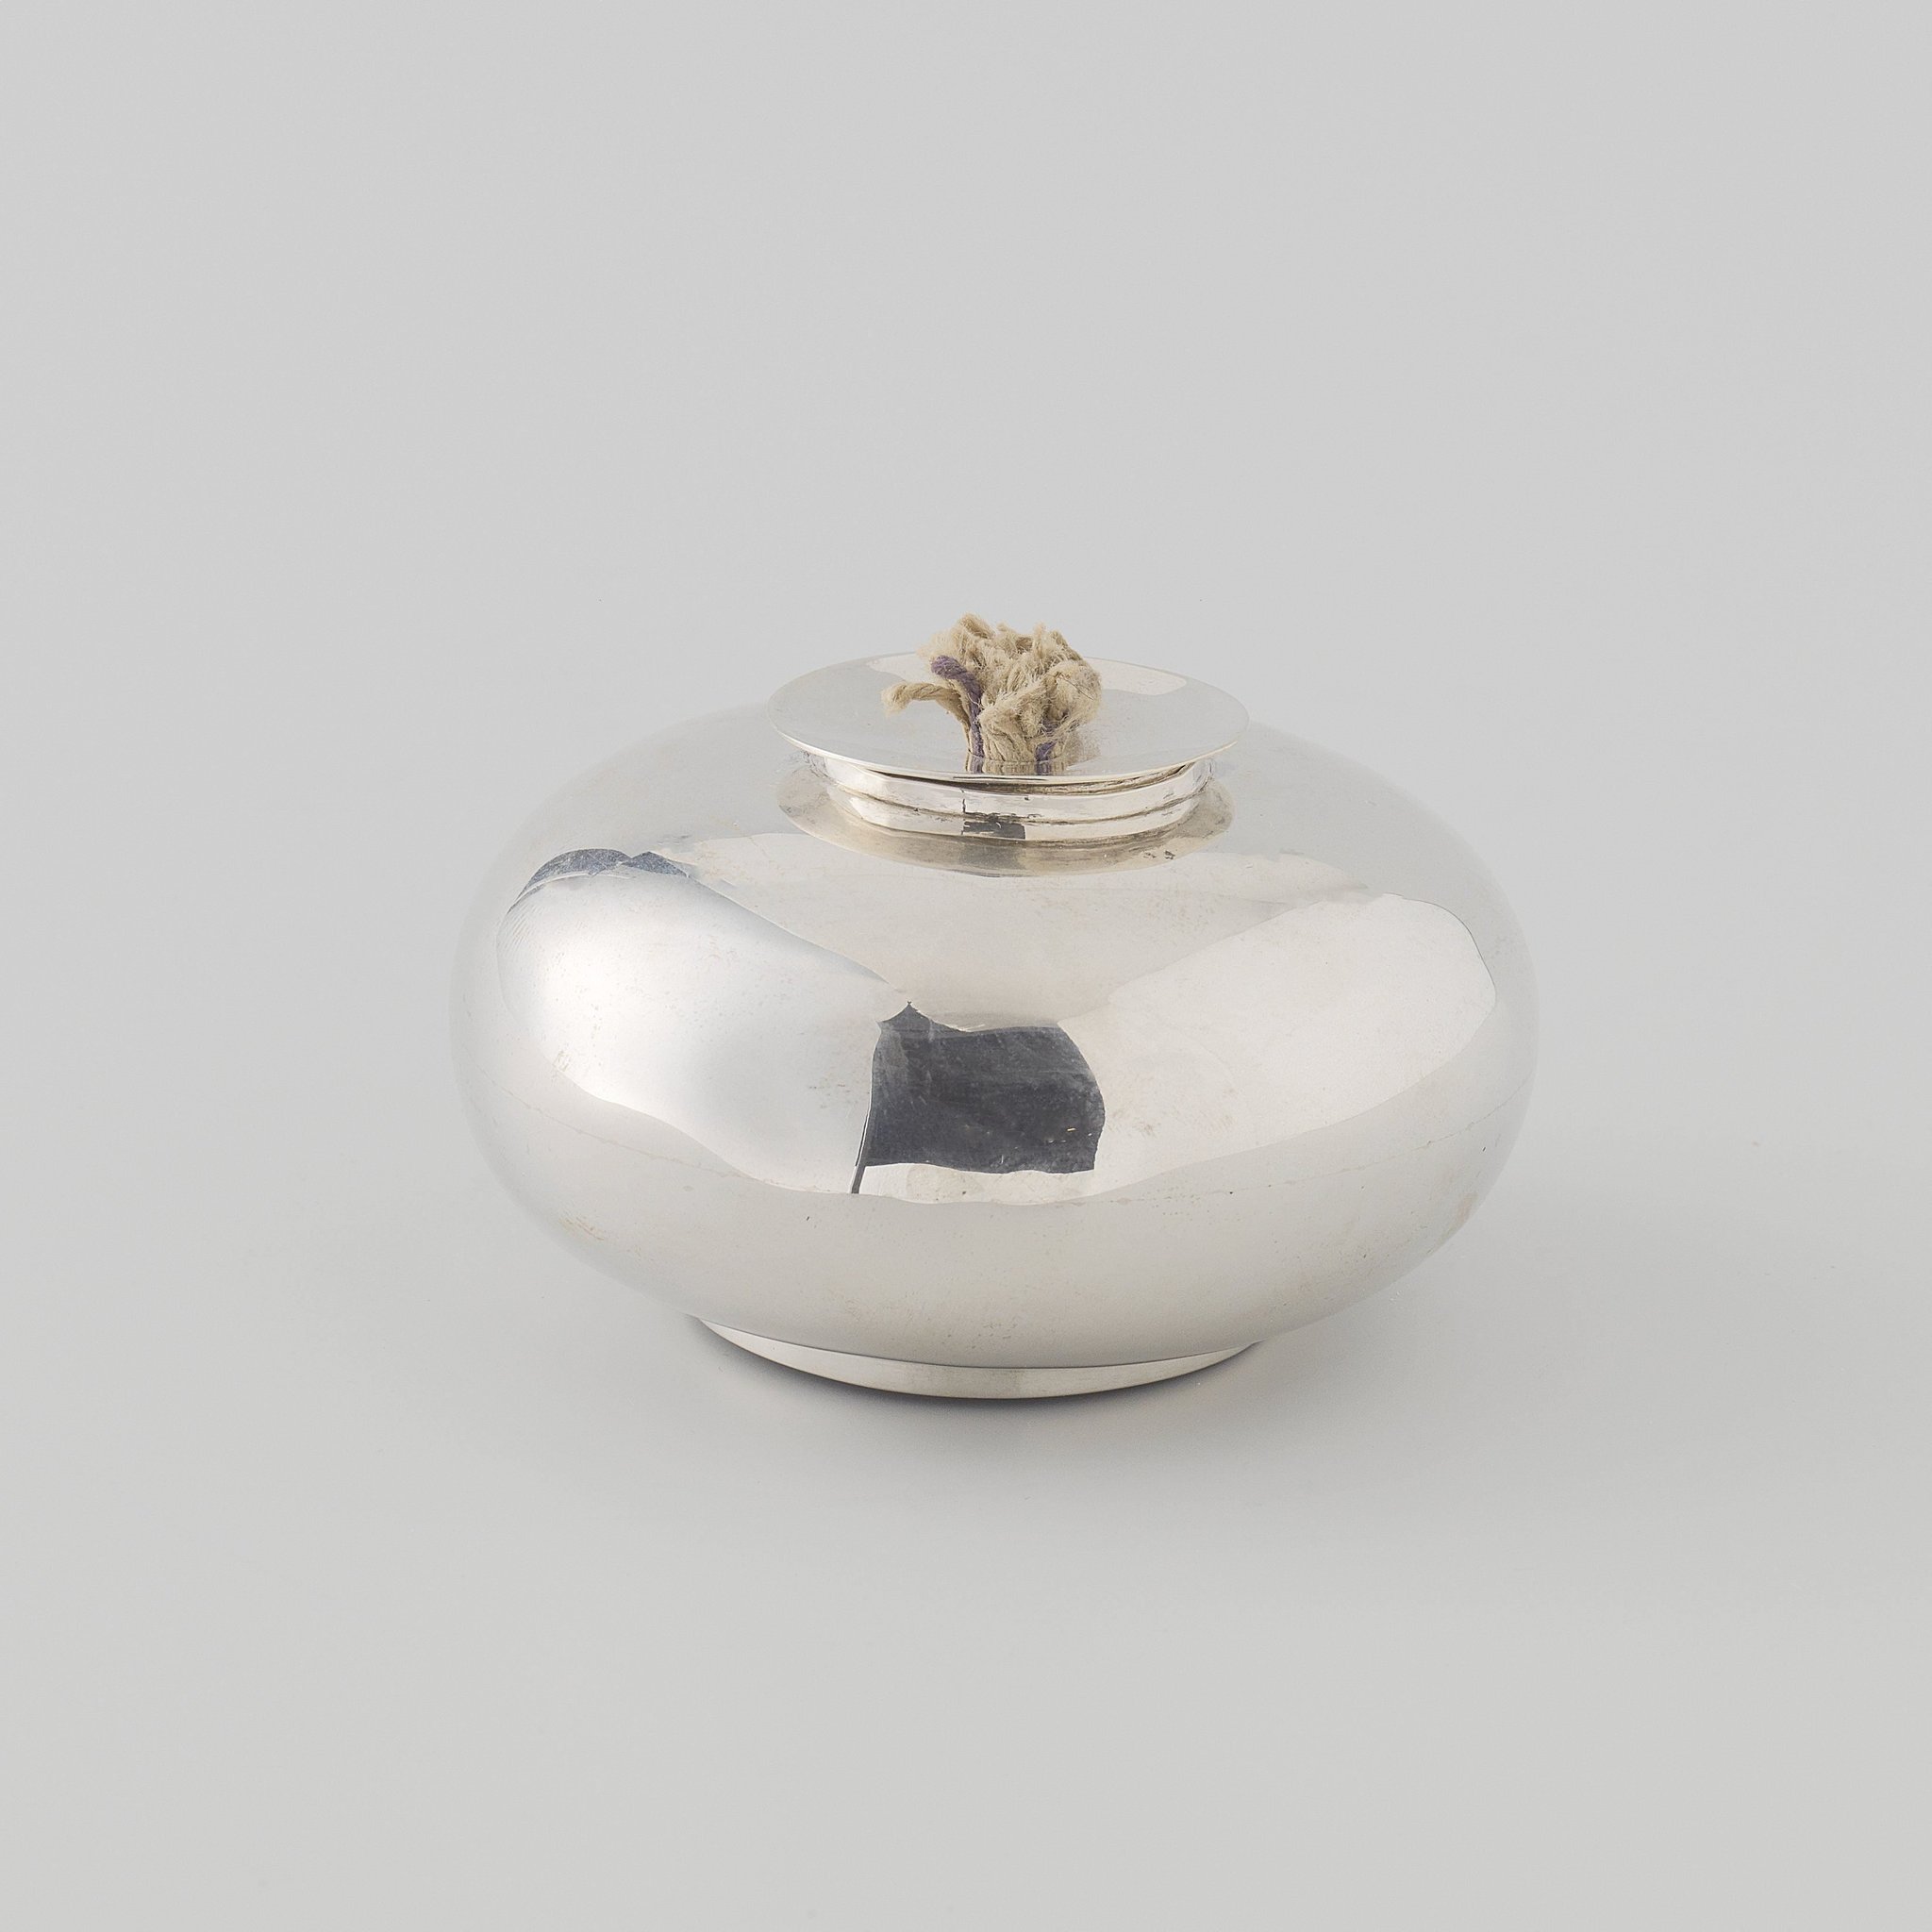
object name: burner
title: Brander, behorend bij komfoor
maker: wijnand warneke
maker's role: silversmith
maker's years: 1738-1810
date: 1778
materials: silver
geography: amsterdam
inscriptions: maker's mark: ‘WW in ovaal’, duty mark: ‘I’, town mark: ‘Amsterdam’, date letter: ‘T’, : ‘Hollandse leeuw’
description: In het midden van het blad van de komfoor is een lage, ronde houder aangebracht, waarin de gedrukt bolvormige brander past.